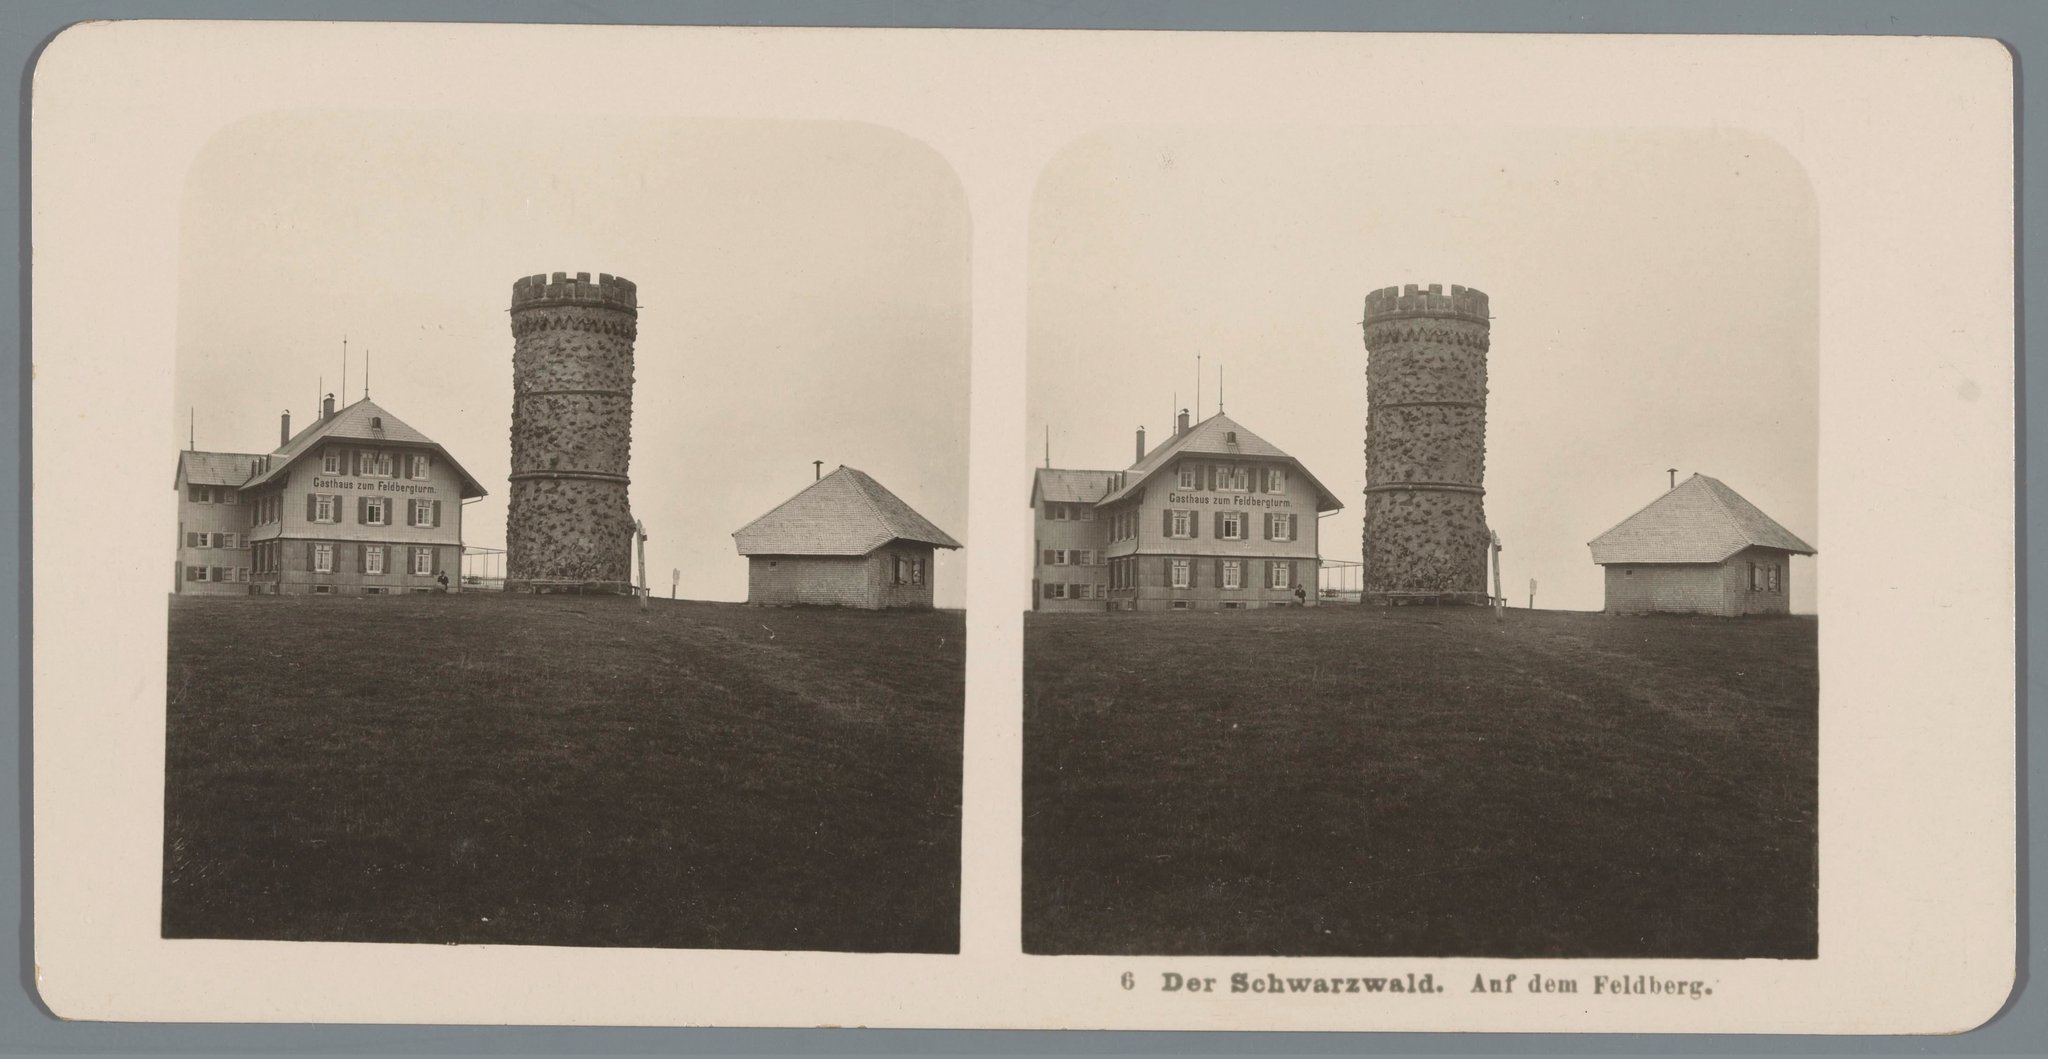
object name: stereograph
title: Gebouwen op de Feldberg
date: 1905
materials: cardboard, photographic support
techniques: gelatin silver print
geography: feldberg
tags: tower, clock tower ~ monumental adornment, façade (of house or building), mountains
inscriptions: inscription: ‘Neue Photographische Gesellschaft A. G. Steglitz-Berlin 1905.’, number: ‘6’